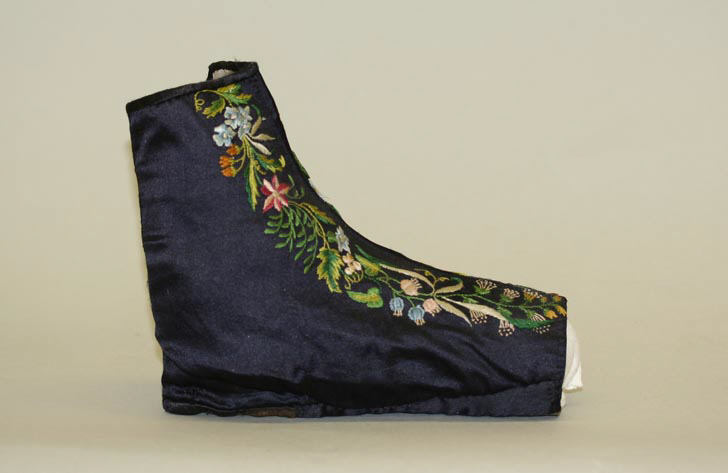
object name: gaiter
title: Gaiters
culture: italian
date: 1801-1900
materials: leather, silk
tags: flowers